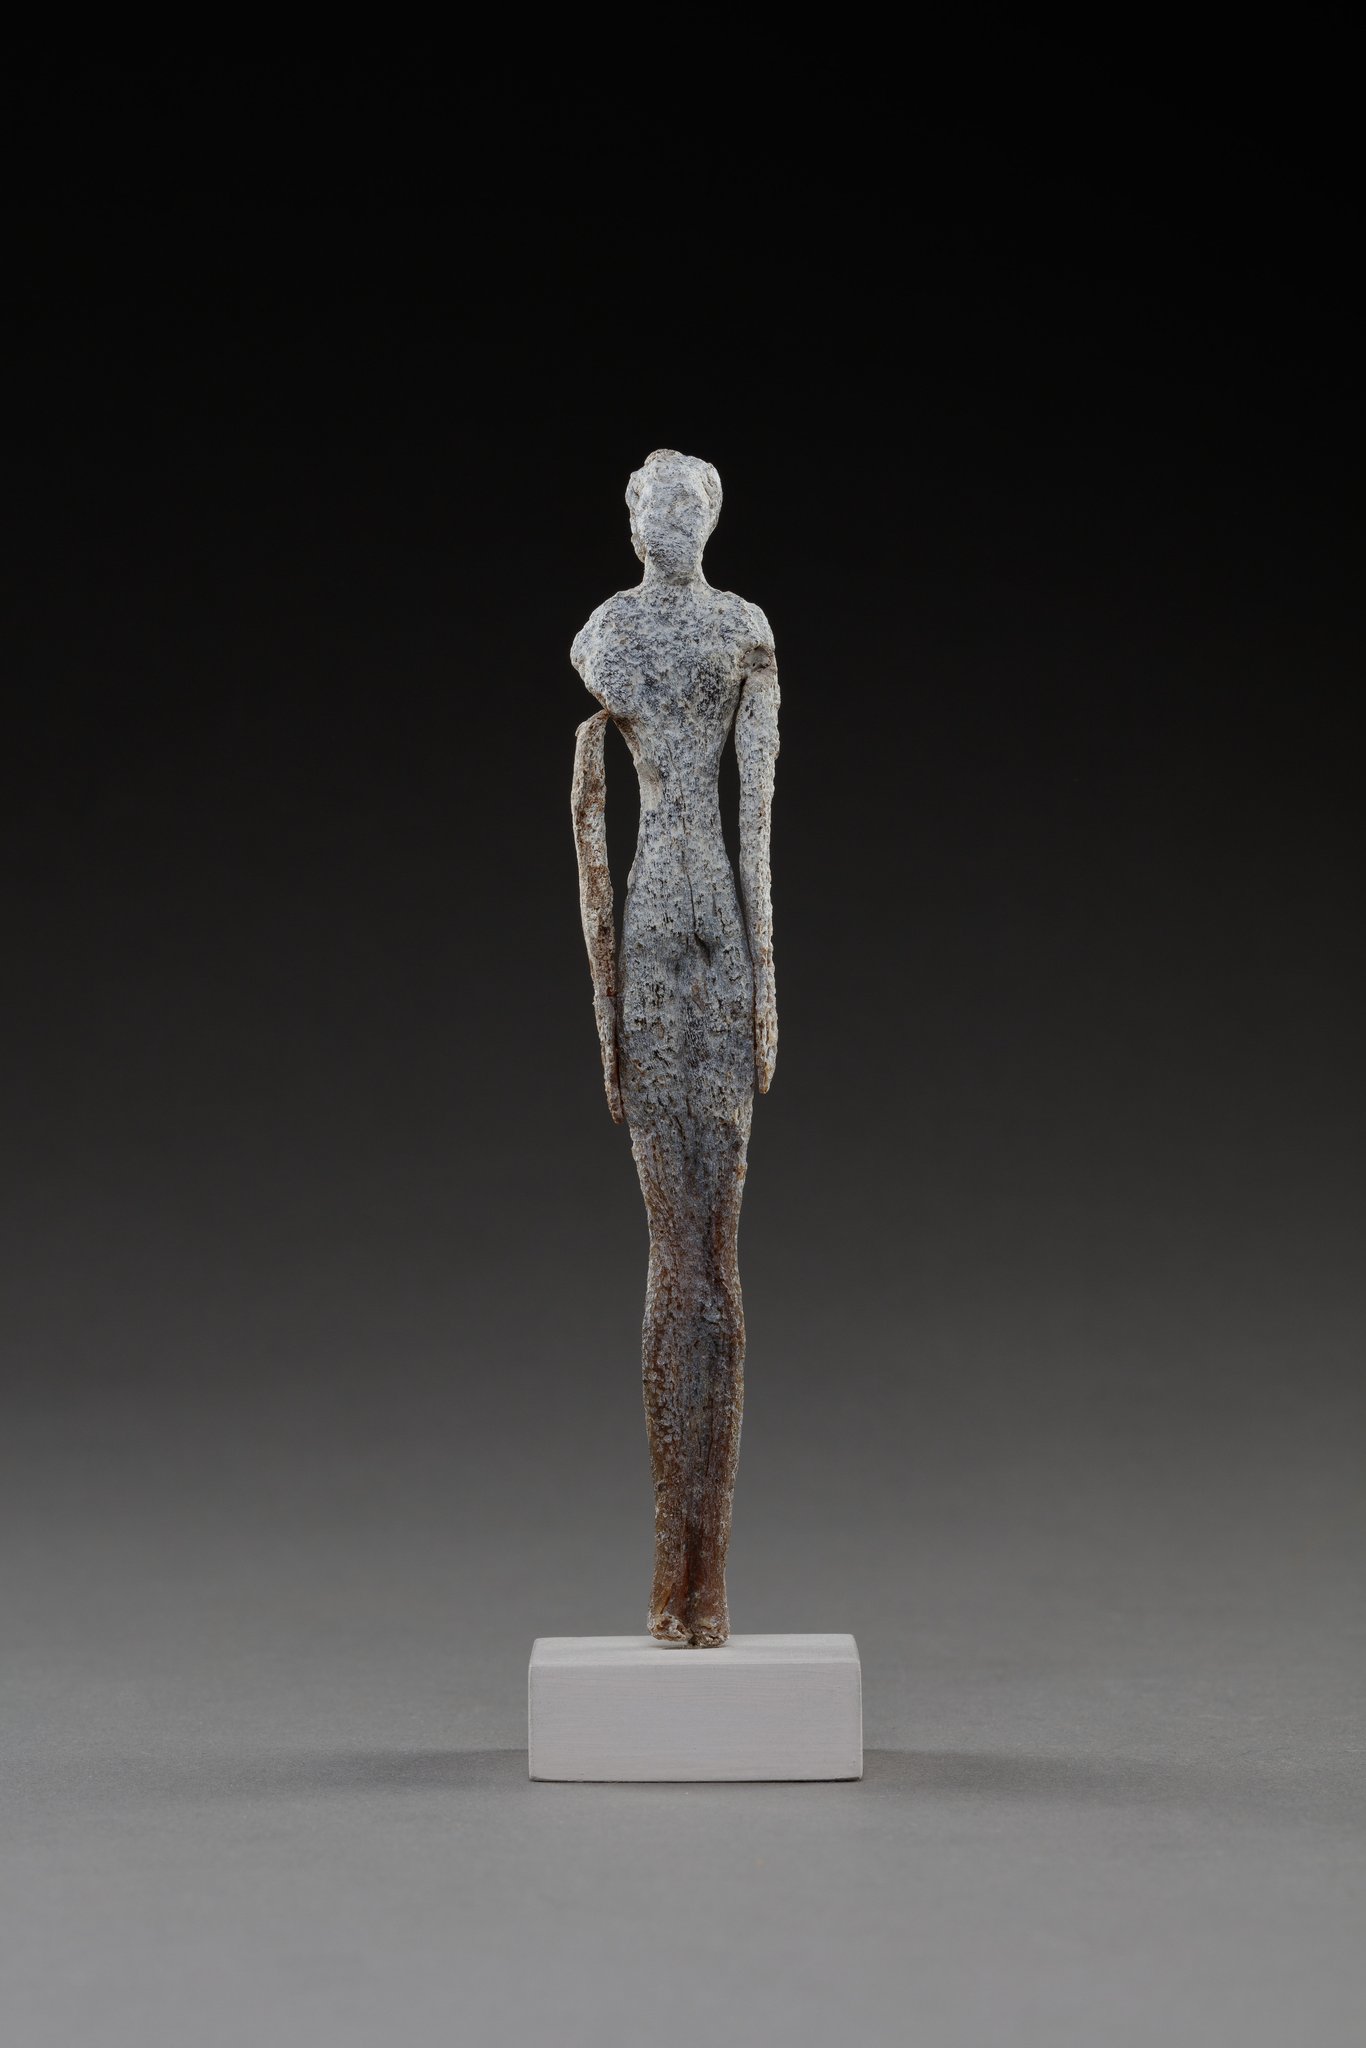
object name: shabti, female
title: Shabti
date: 2124-1981 BCE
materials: wax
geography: egypt